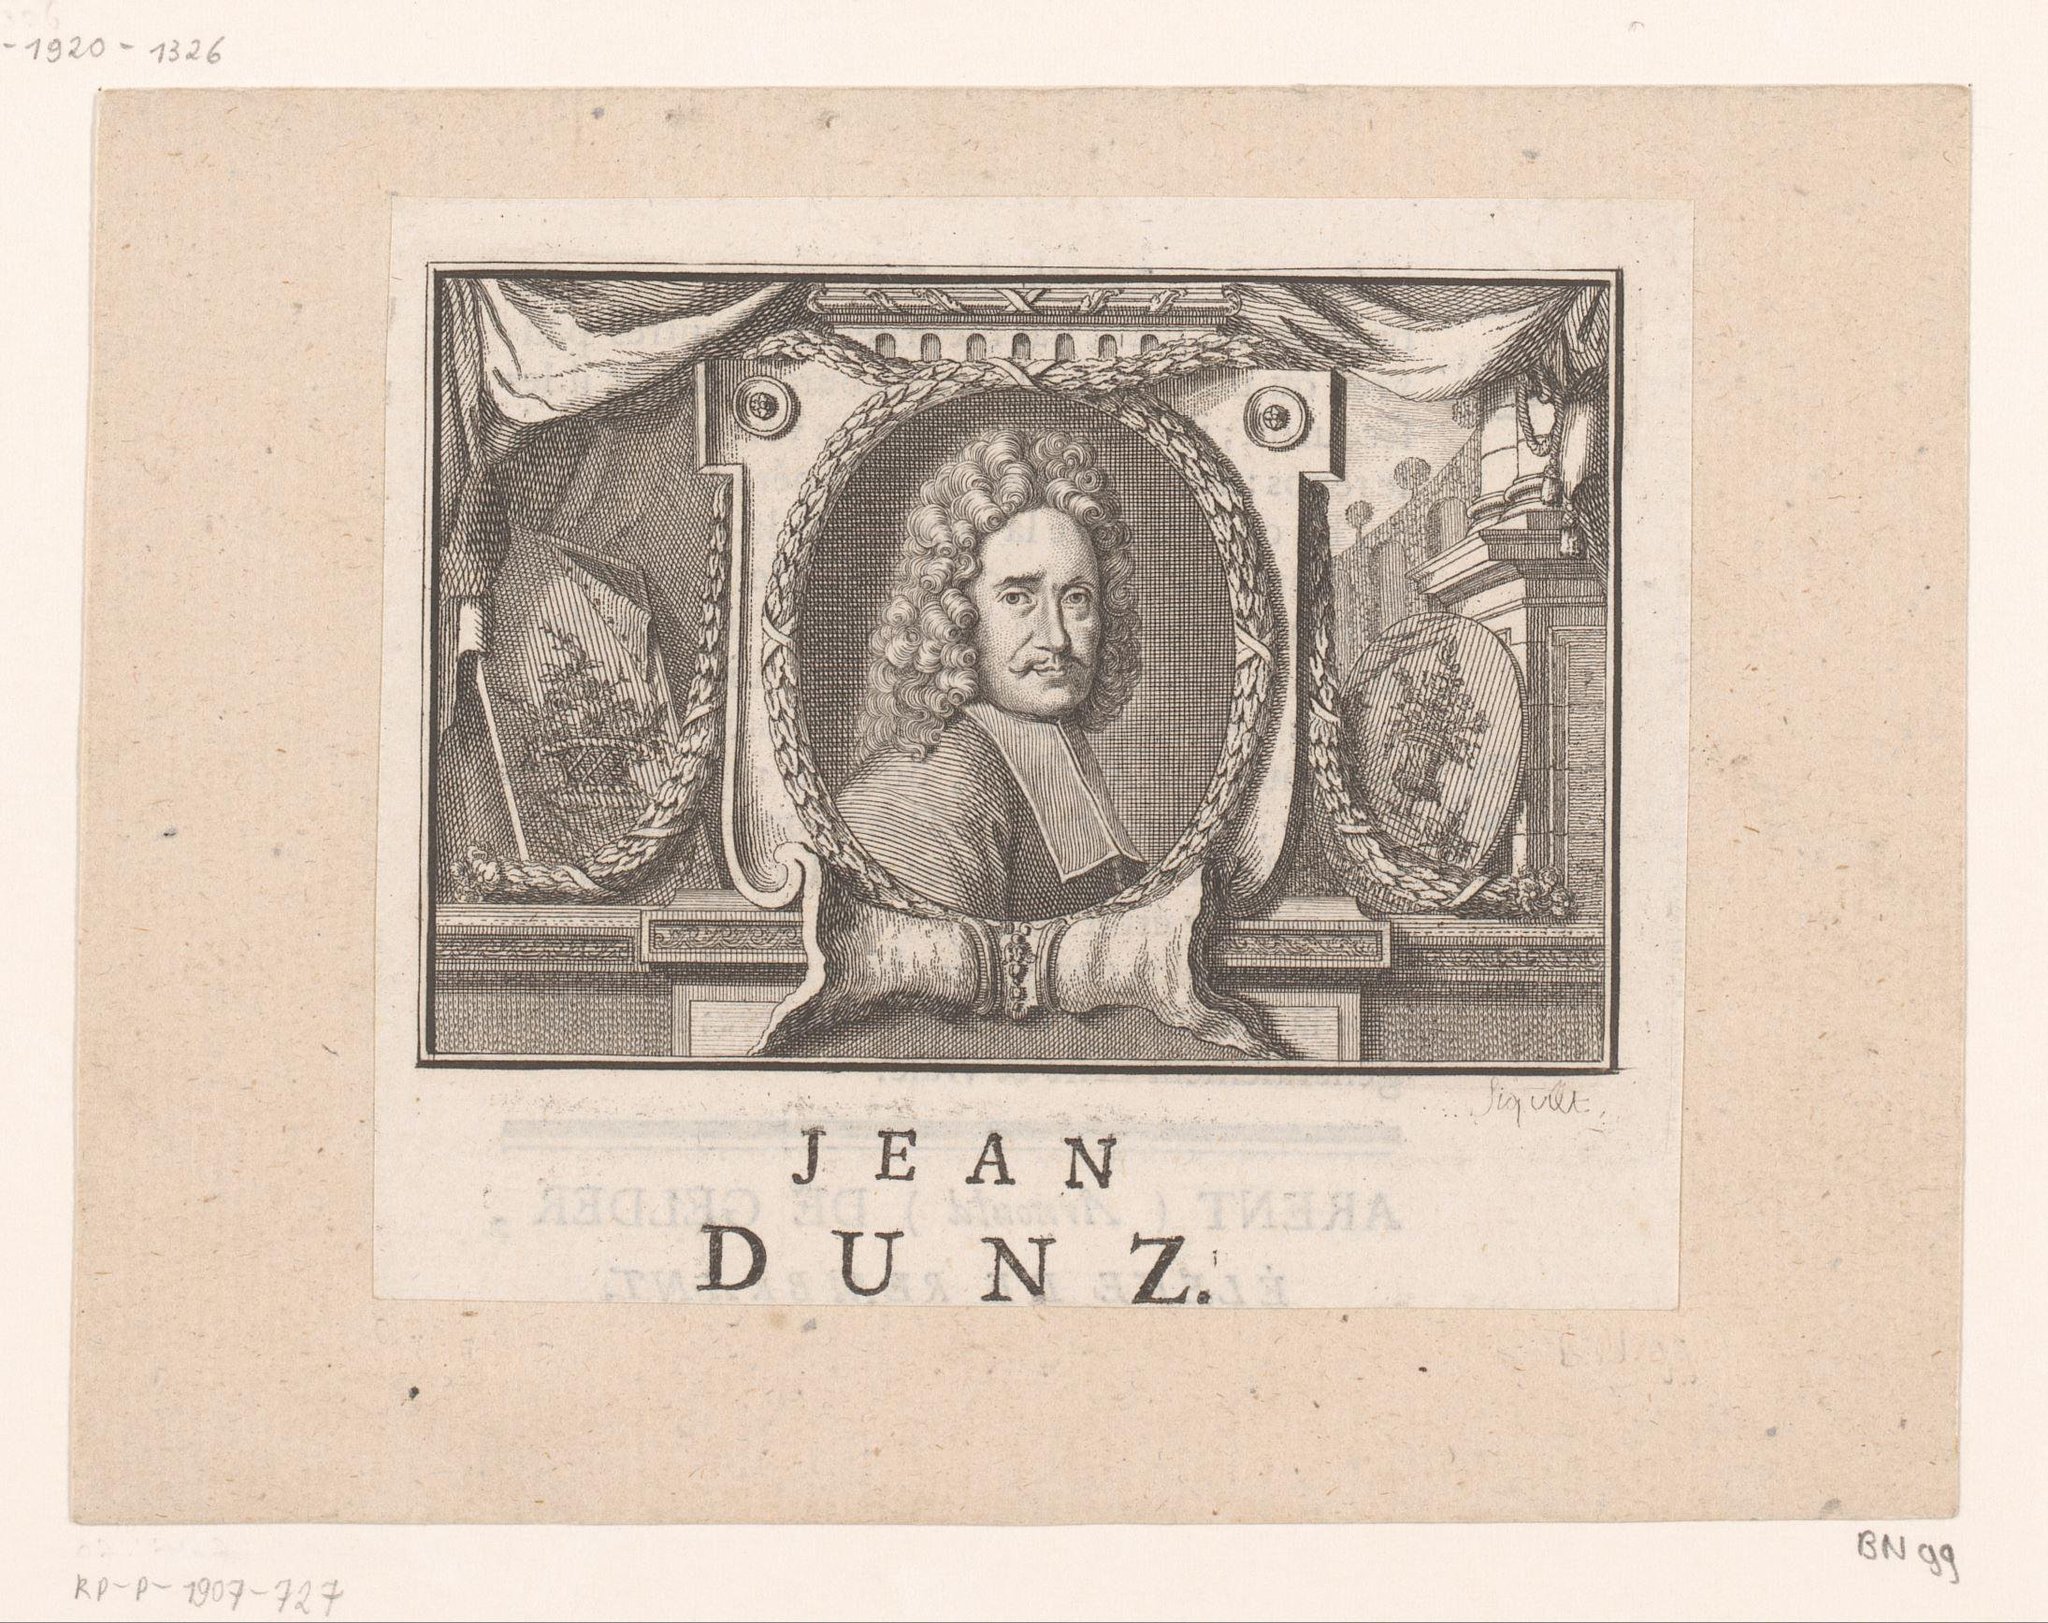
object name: book illustration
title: Portret van Jean Dunz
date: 1753-1764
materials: paper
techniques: engraving, etching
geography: france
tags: ornament ~ medallion, portrait, self-portrait of painter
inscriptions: collector's mark: Lugt 2228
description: Prent uit: Descamps. La vie des peintres flamands allemands et hollandois (..). Parijs: Jombert, 1753-1764.